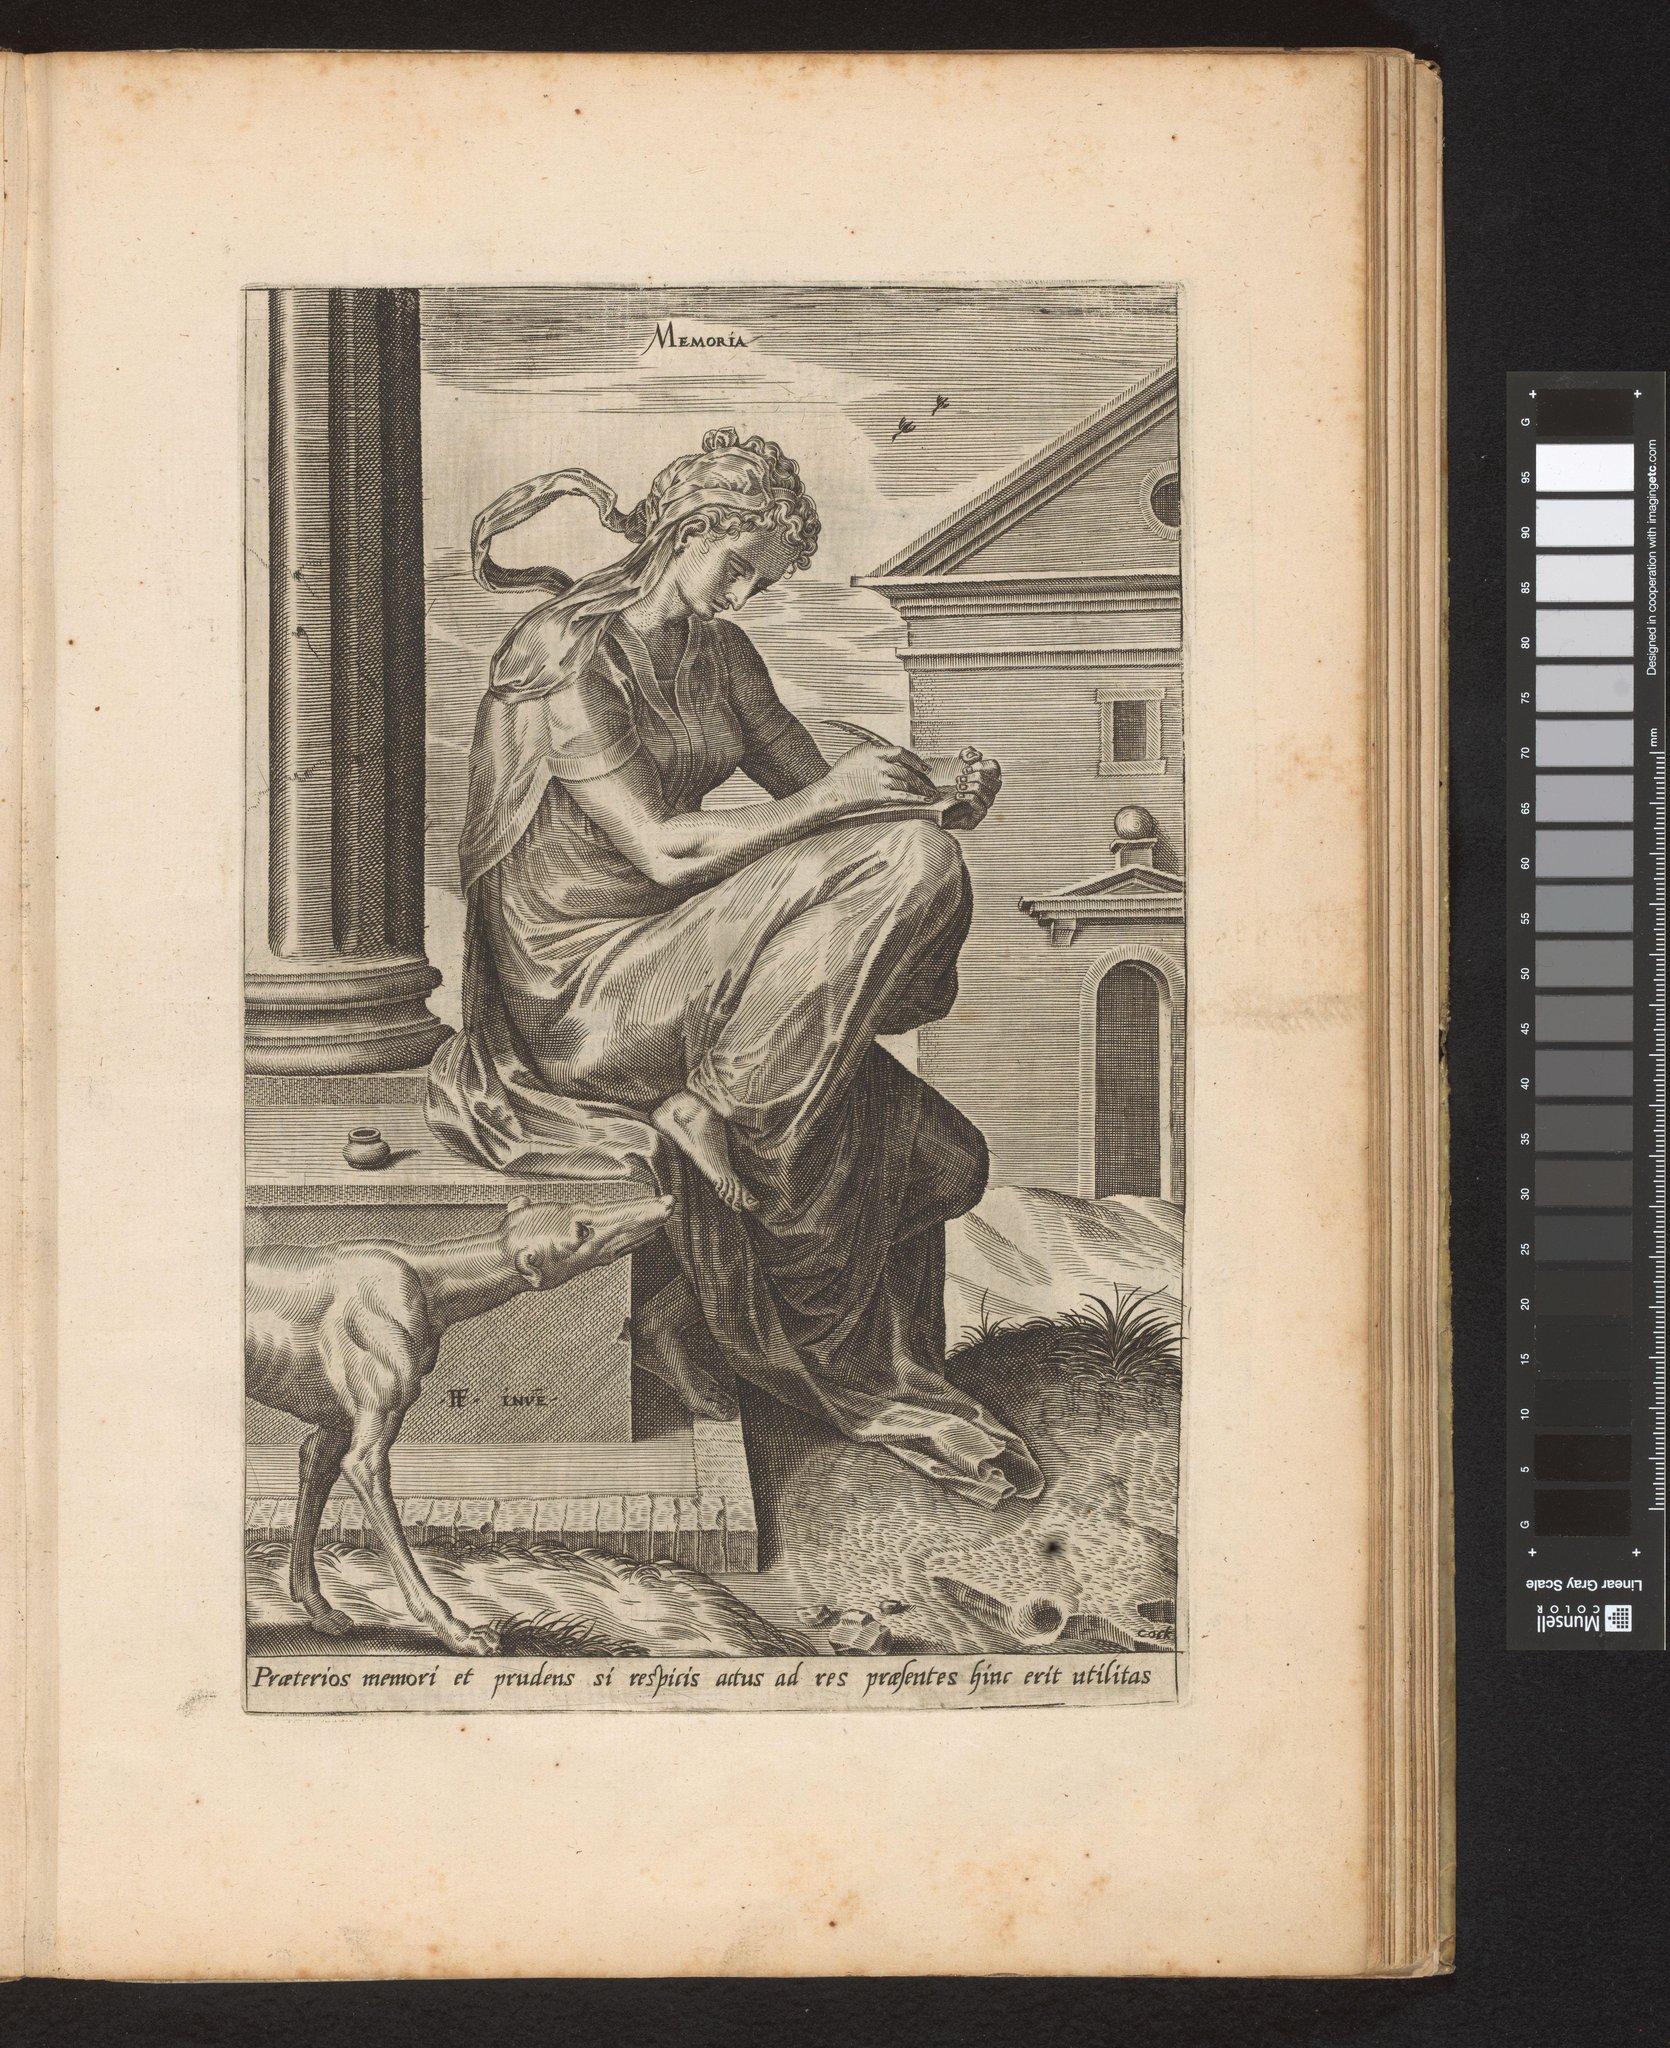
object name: print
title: Deugden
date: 1560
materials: paper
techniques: engraving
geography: antwerp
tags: memory; 'memoria' (ripa) (+ abstract concept represented by female figure)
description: De personificatie van het Geheugen zit op het basement van een zuil en tekent in een boek de geschiedenis op. Naast haar een hond. Deze prent maakt deel uit van een album.